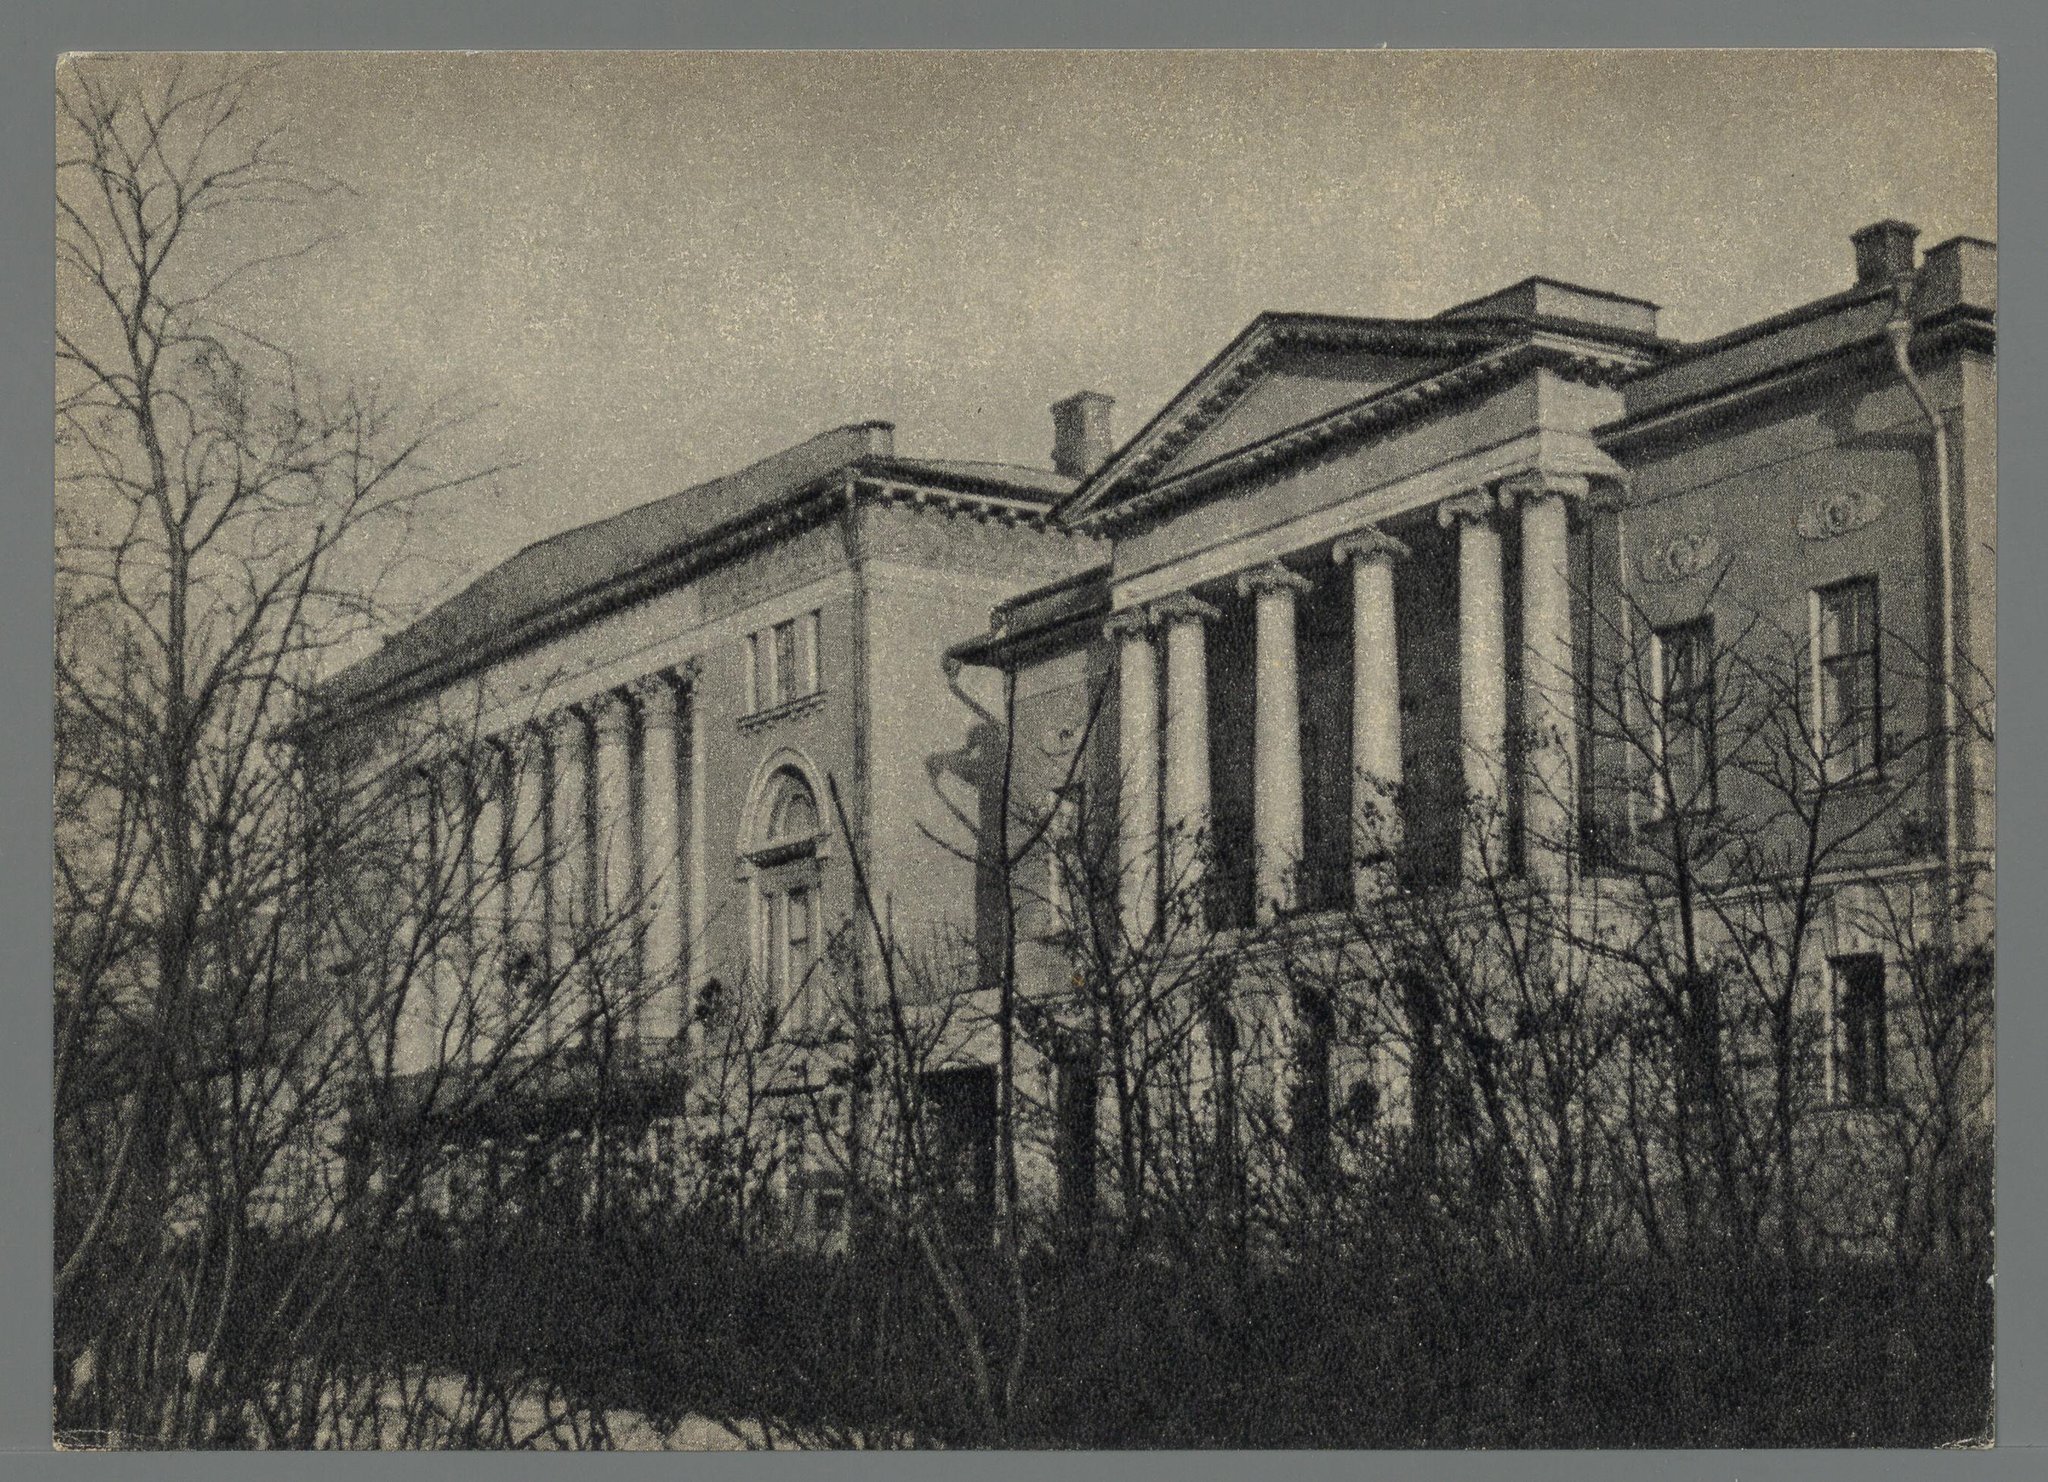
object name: photomechanical print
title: Gezicht op het huis van Lenin te Moskou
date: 1957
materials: cardboard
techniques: rotogravure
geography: moscow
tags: urban housing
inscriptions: date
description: De titel op object staat in het Russisch.